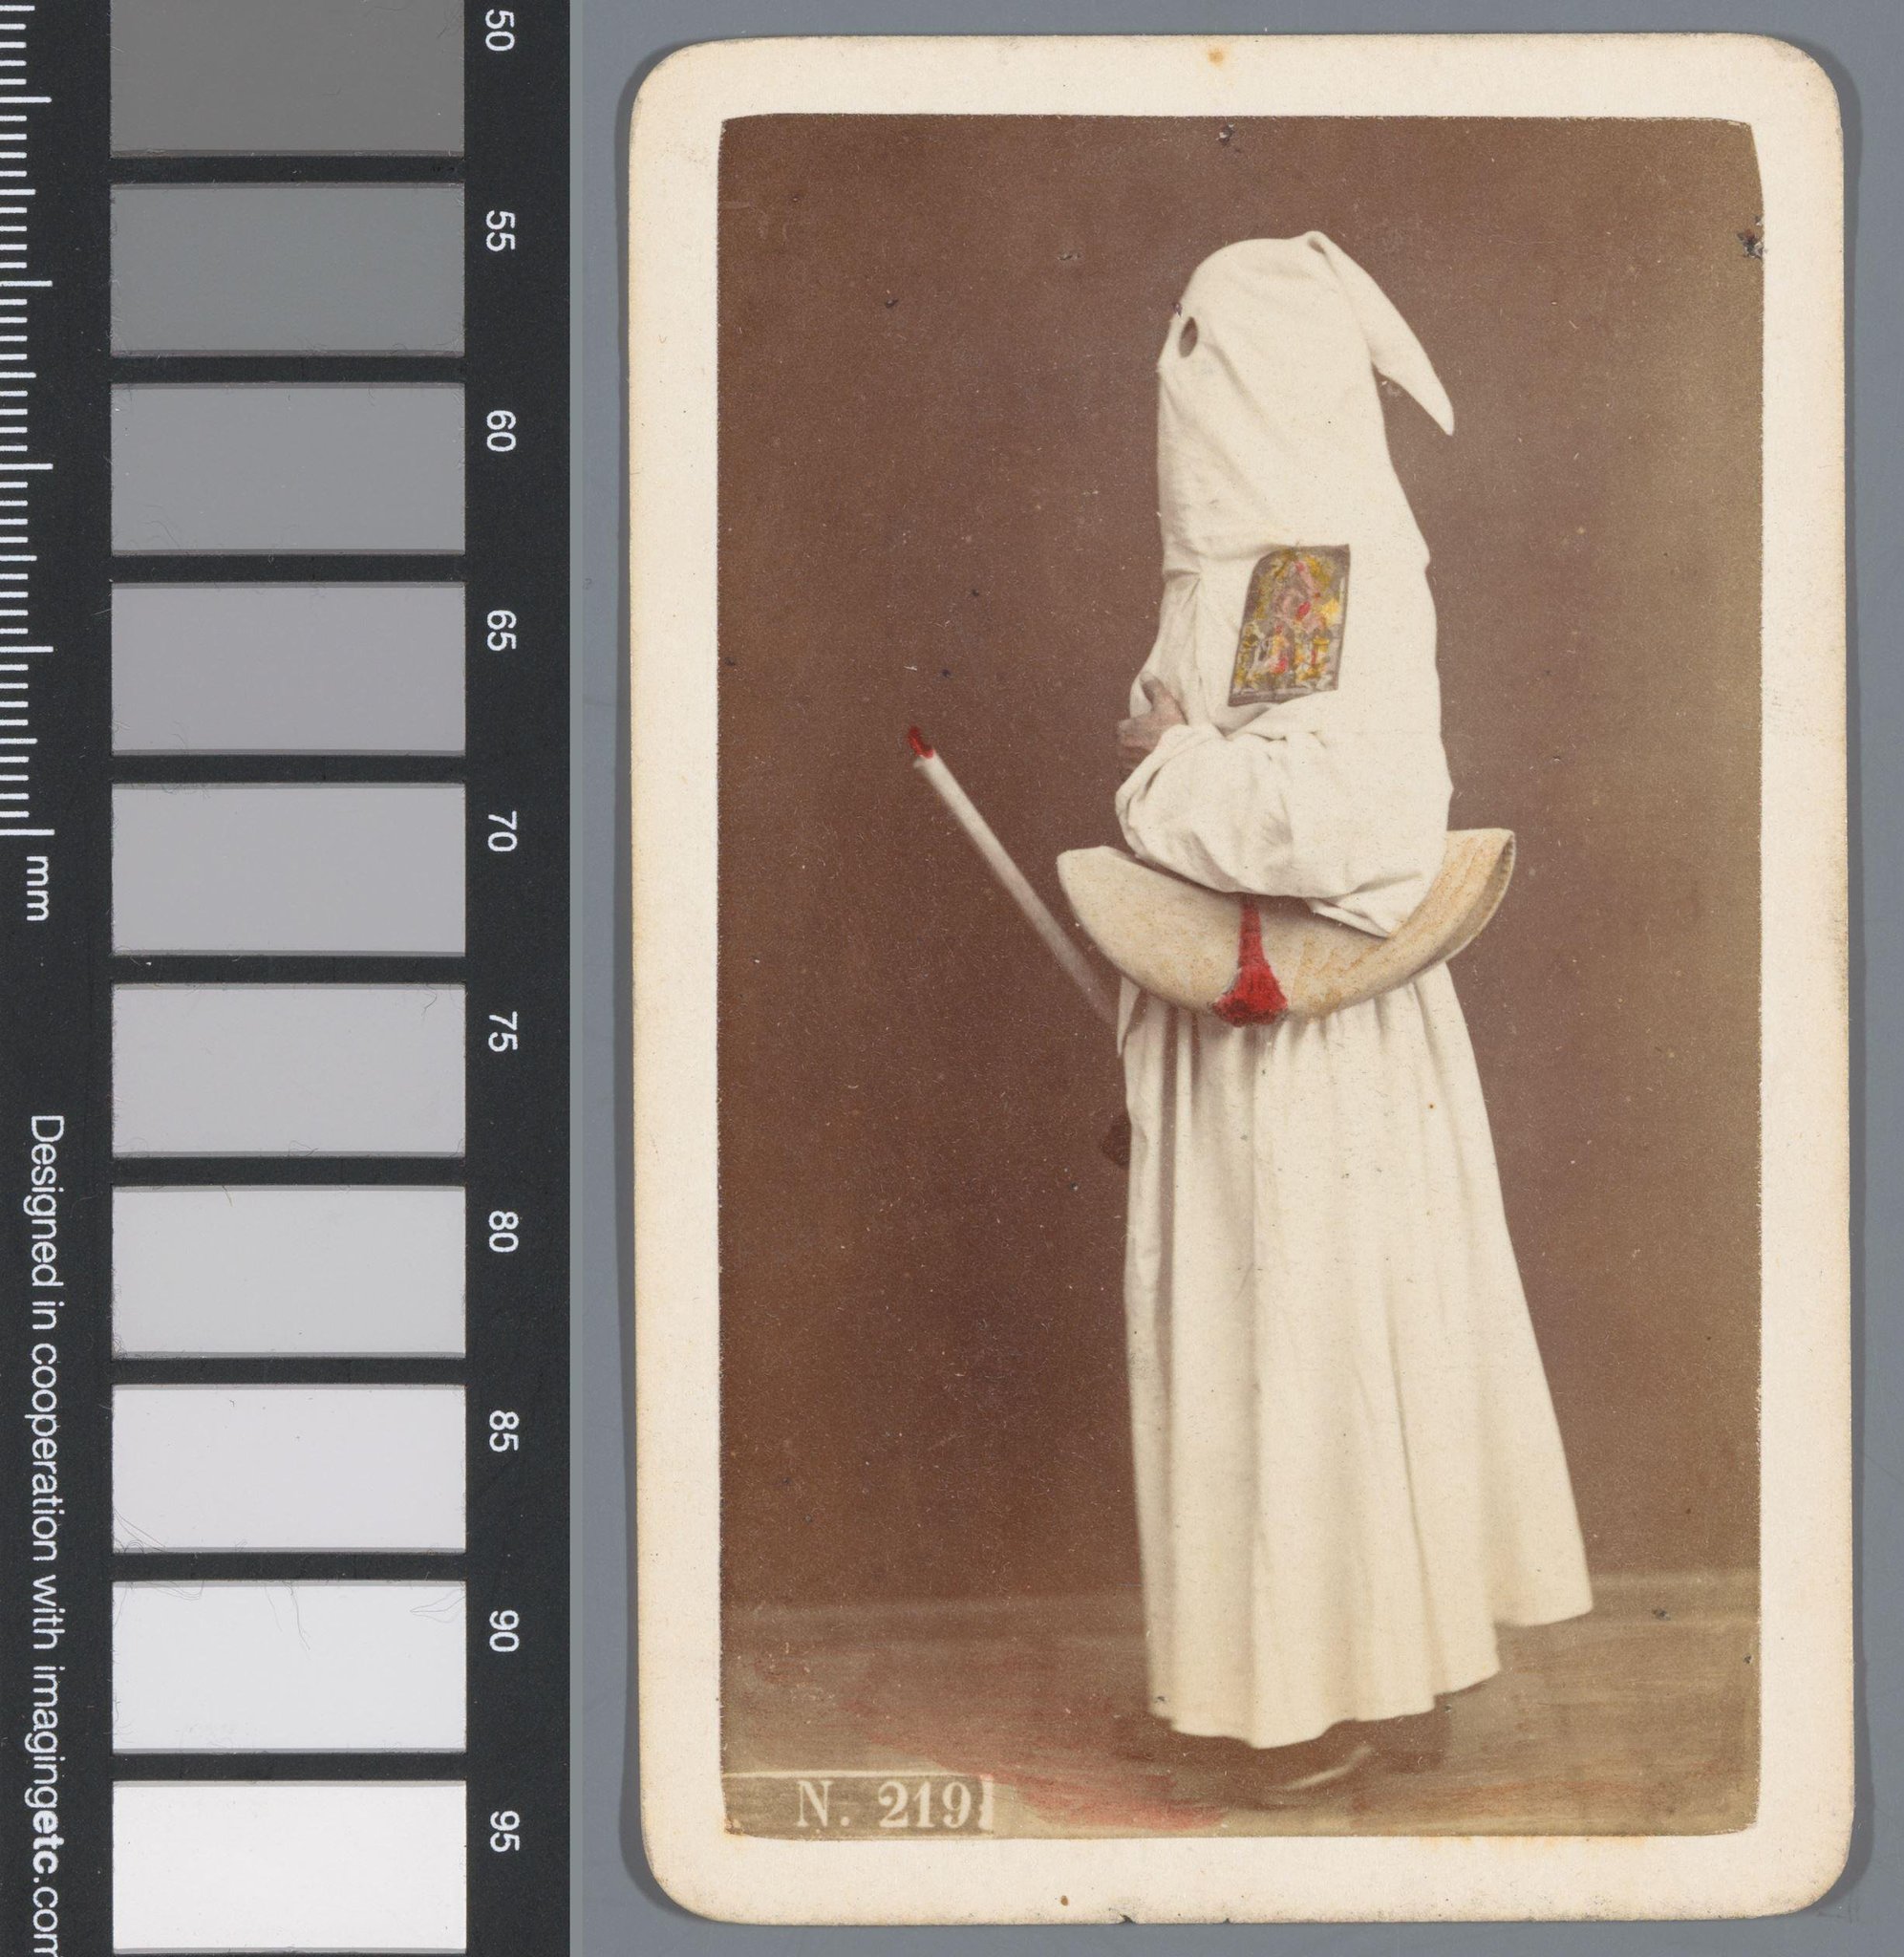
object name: photograph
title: Portret van een onbekend persoon gekleed in een witte mantel met kap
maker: giorgio conrad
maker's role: fotograaf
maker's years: 1827-1889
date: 1860-1880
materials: cardboard, paper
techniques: albumen print, hand coloring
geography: naples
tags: anonymous historical person portrayed, coat, cape, naples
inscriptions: address: ‘Strada fontana Medina 54/ NAPOLI’, number: ‘N. 219’